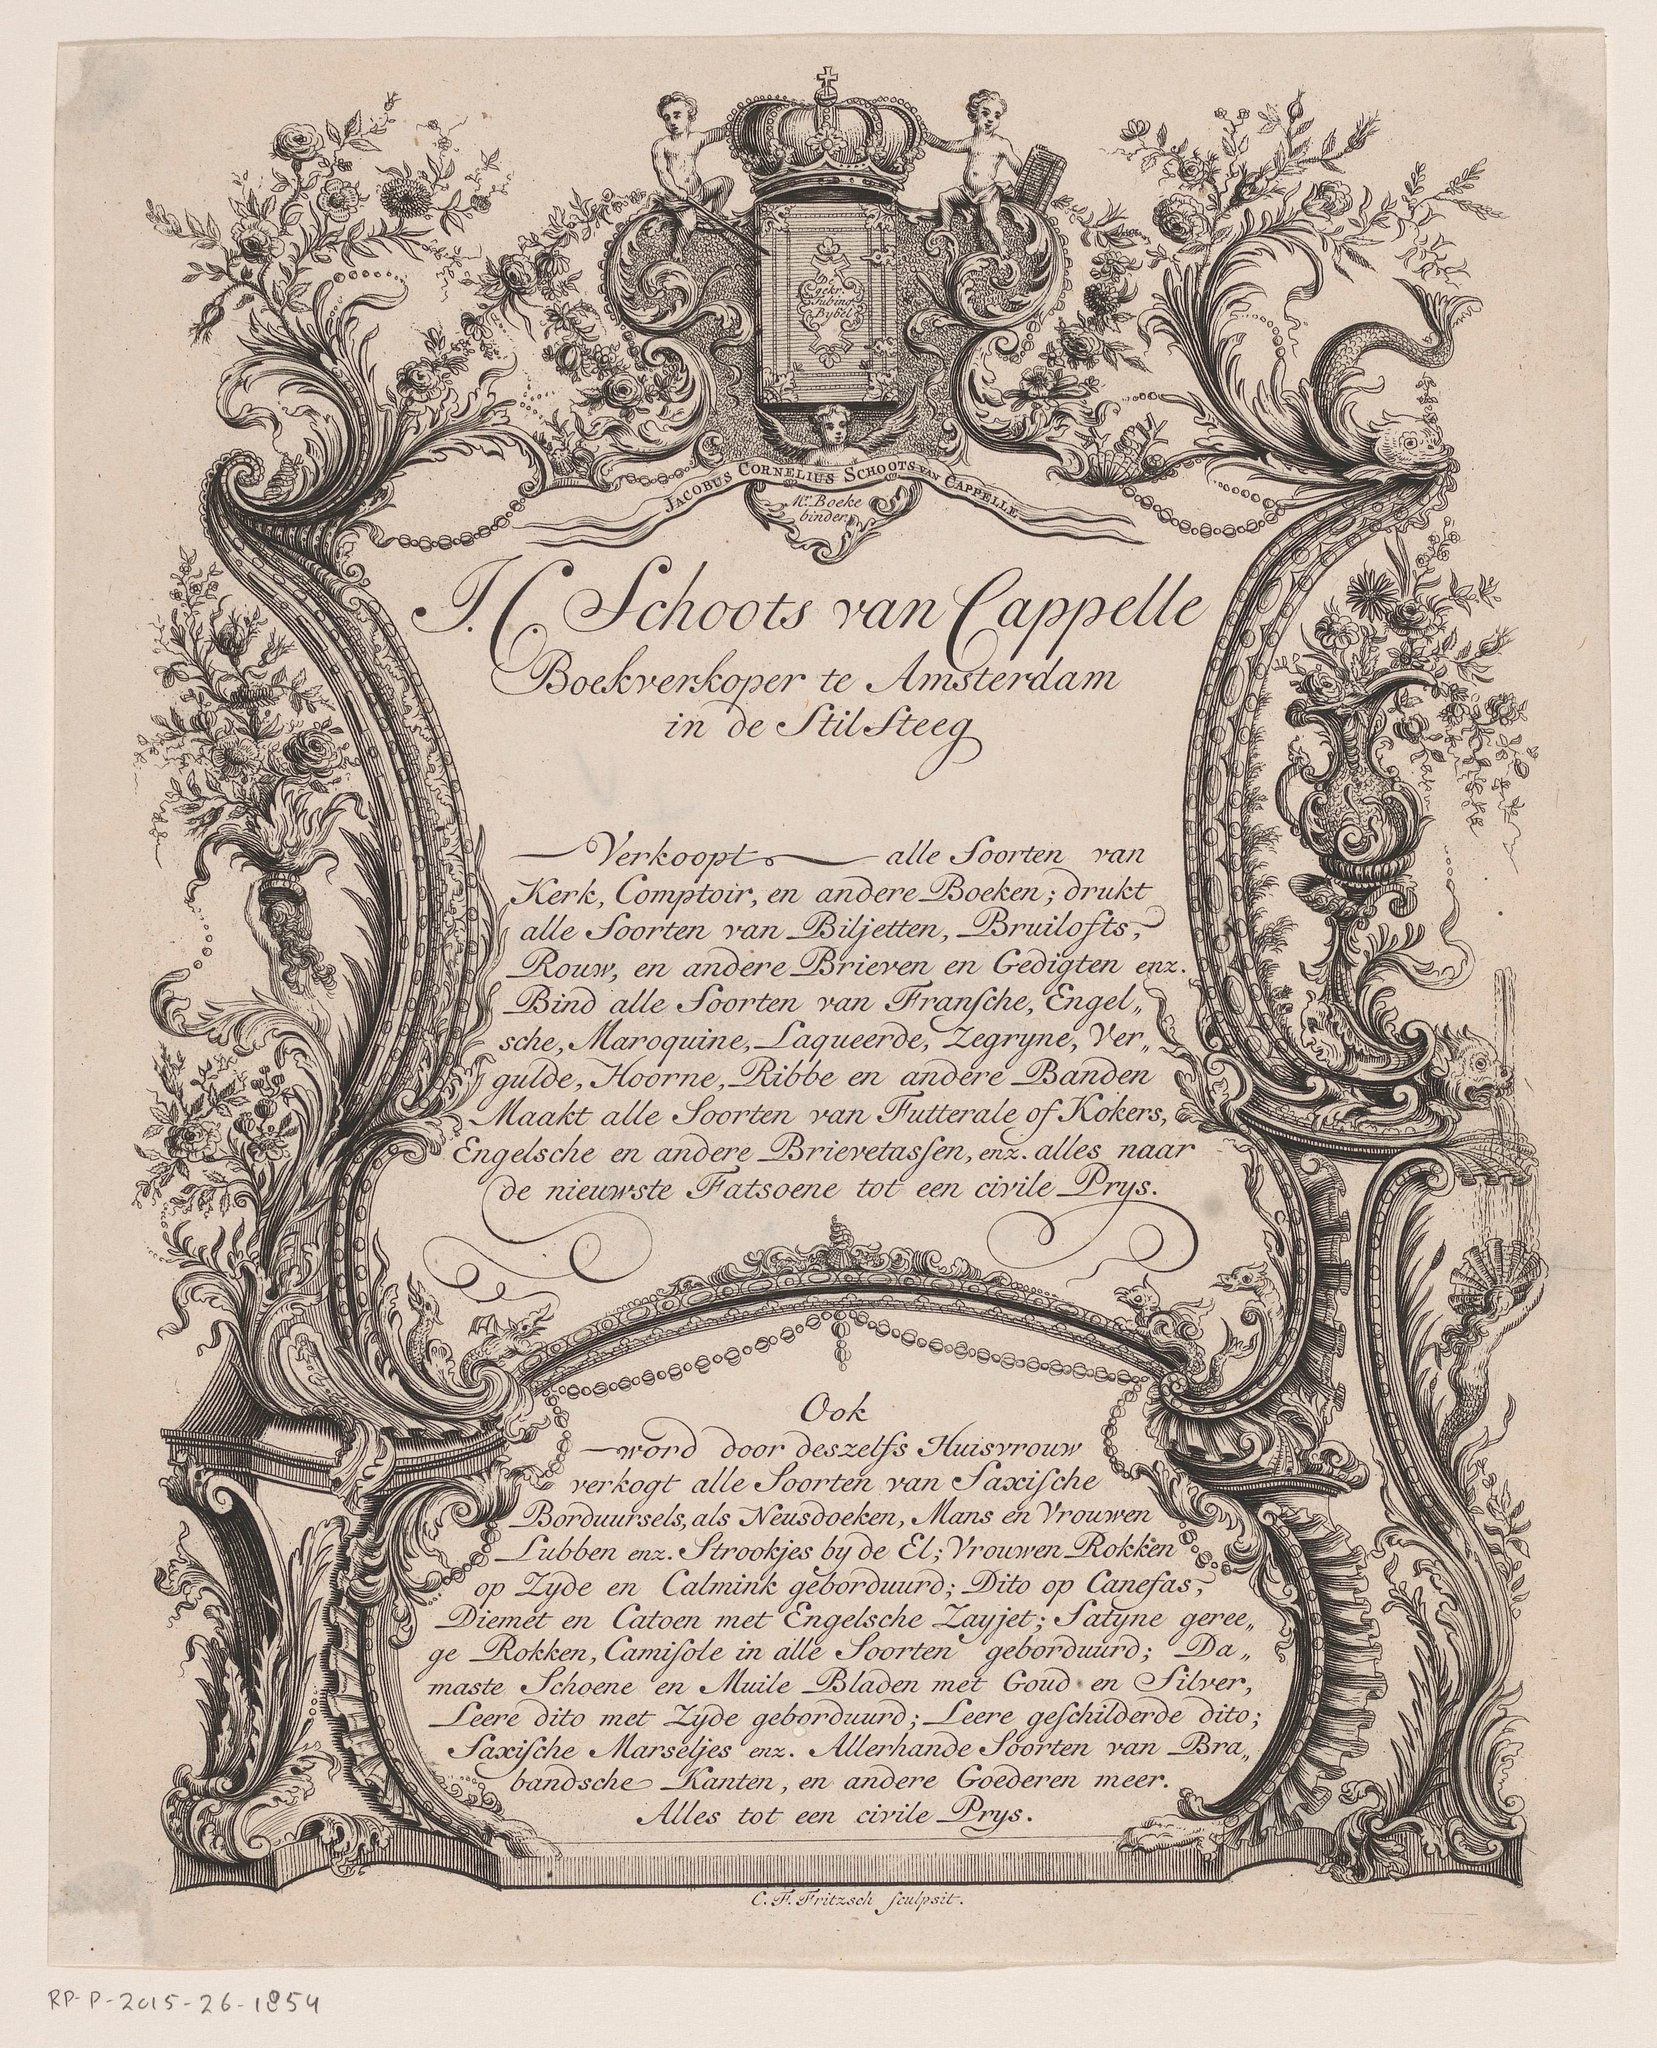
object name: print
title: Reclame voor Jacobus Cornelius Schoots van Cappelle, boekverkoper te Amsterdam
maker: christian friedrich fritzsch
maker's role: print maker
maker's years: 1719-1774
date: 1750-1766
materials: paper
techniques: etching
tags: rocaille ornament, flowers ~ ornament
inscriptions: collector's mark: Lugt 4779, collector's mark: Lugt 2228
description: Tekst in een rocaille omlijsting met bloemen, fantasiewezens en vissen. Boven drie putti rond een boekband met een kroon.